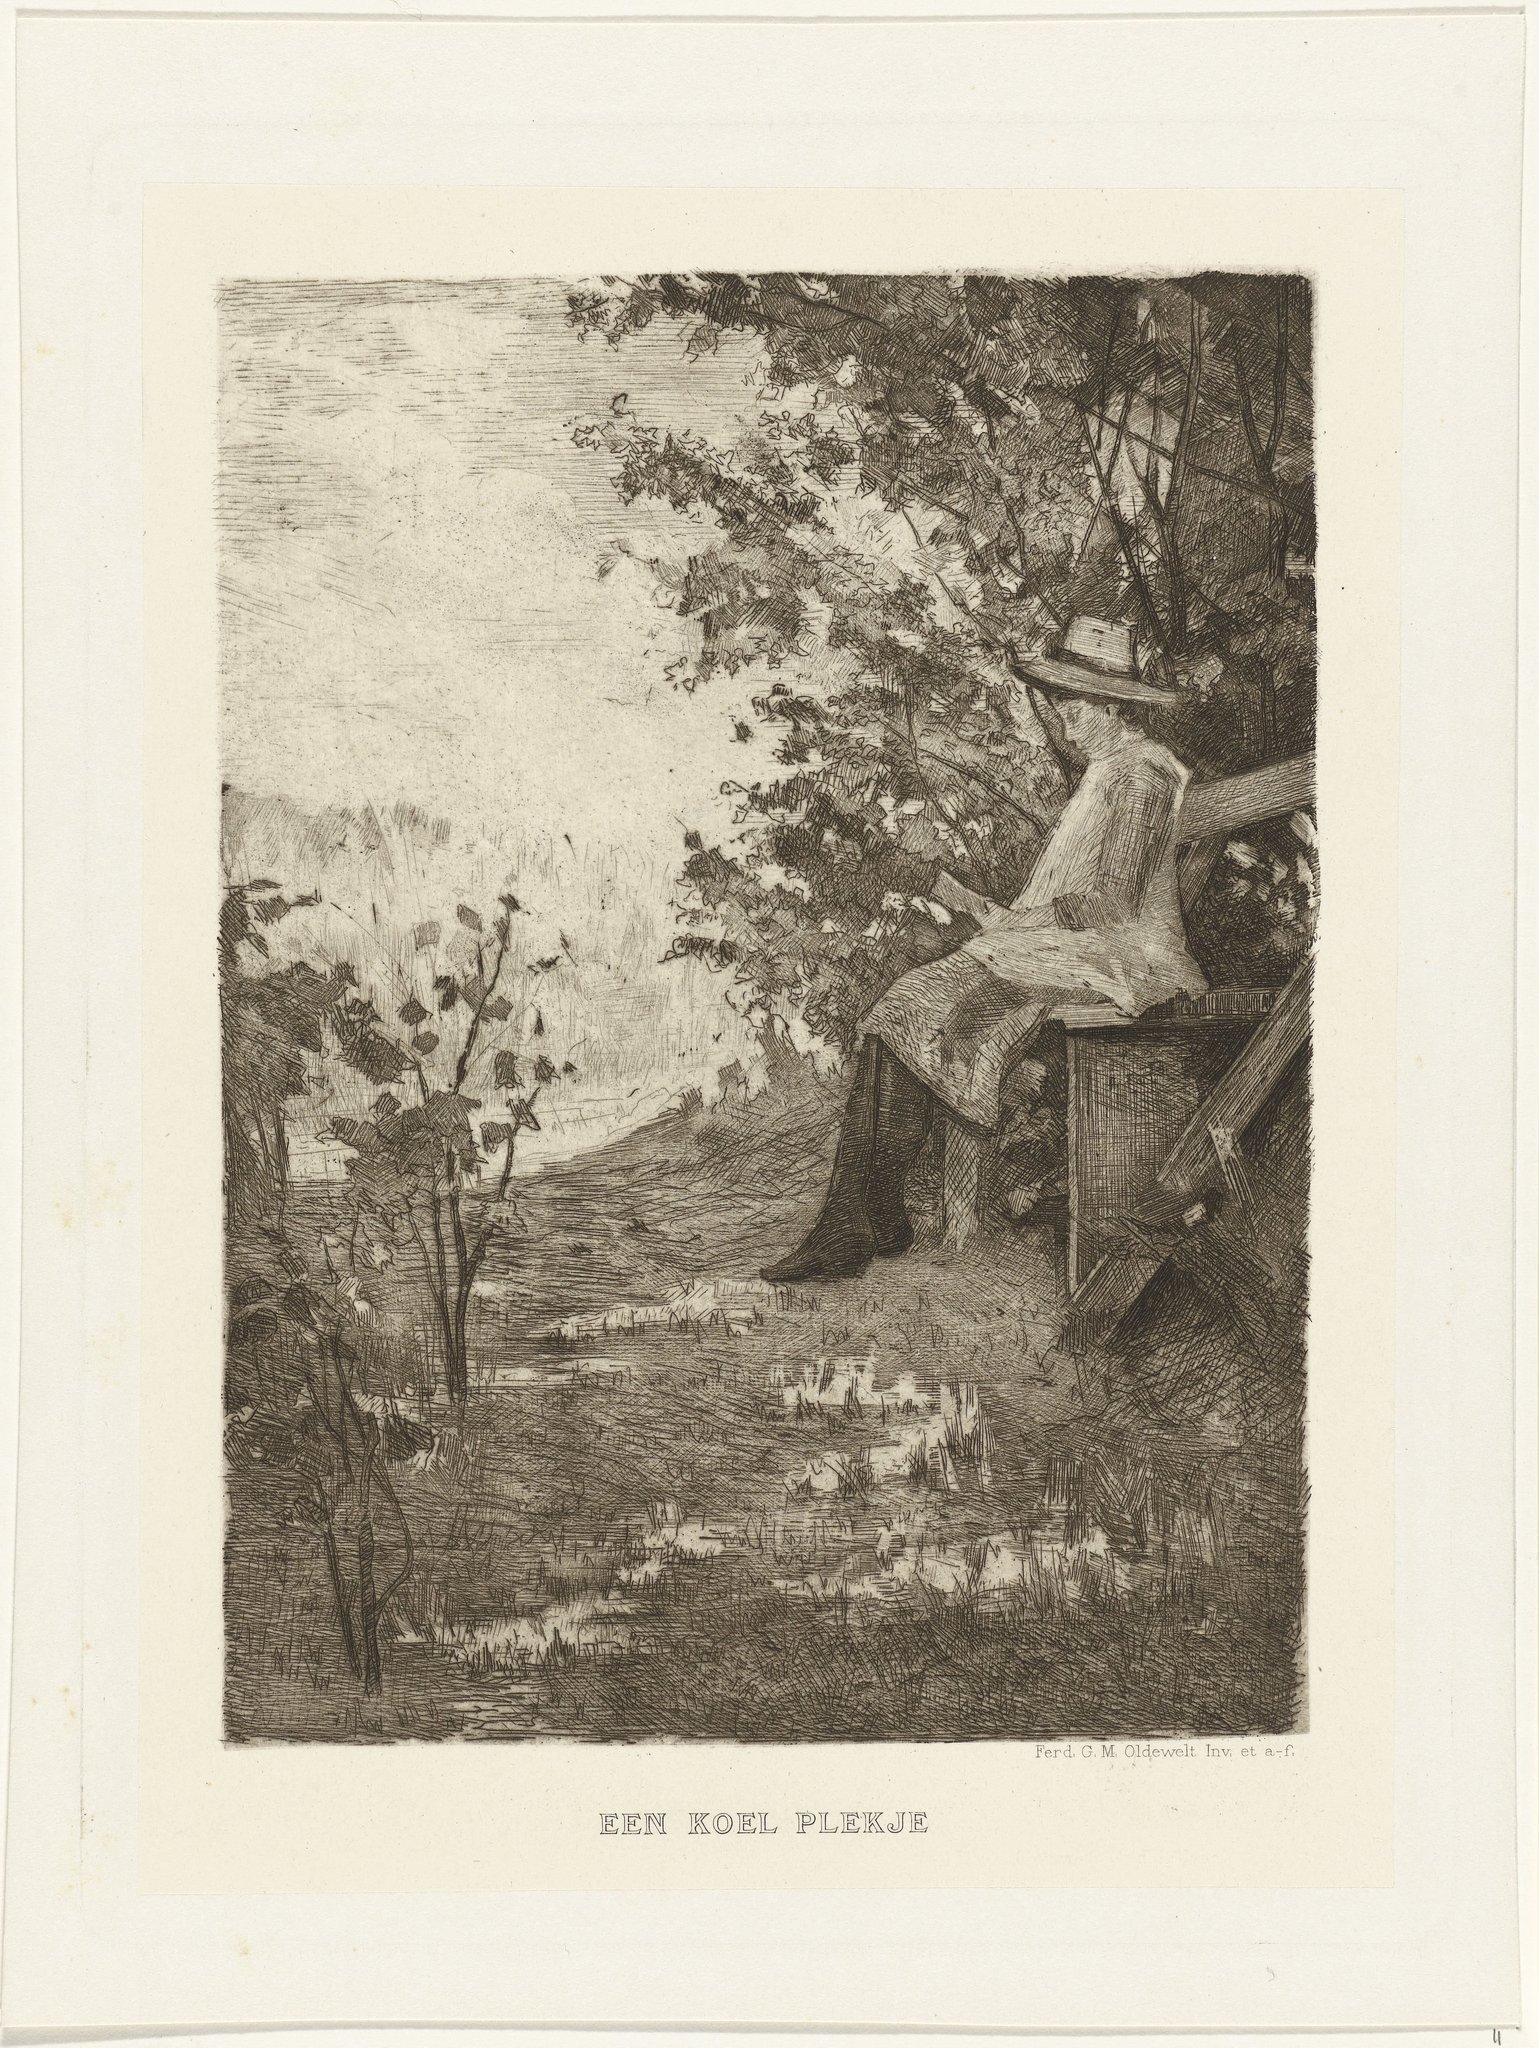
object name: print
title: Lezend jongetje op een bank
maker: ferdinand oldewelt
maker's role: draughtsman, print maker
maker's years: 1857-1935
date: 1872-1913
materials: paper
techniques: drypoint, etching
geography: netherlands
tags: reading, boy (child between toddler and youth)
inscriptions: collector's mark: Lugt 2228